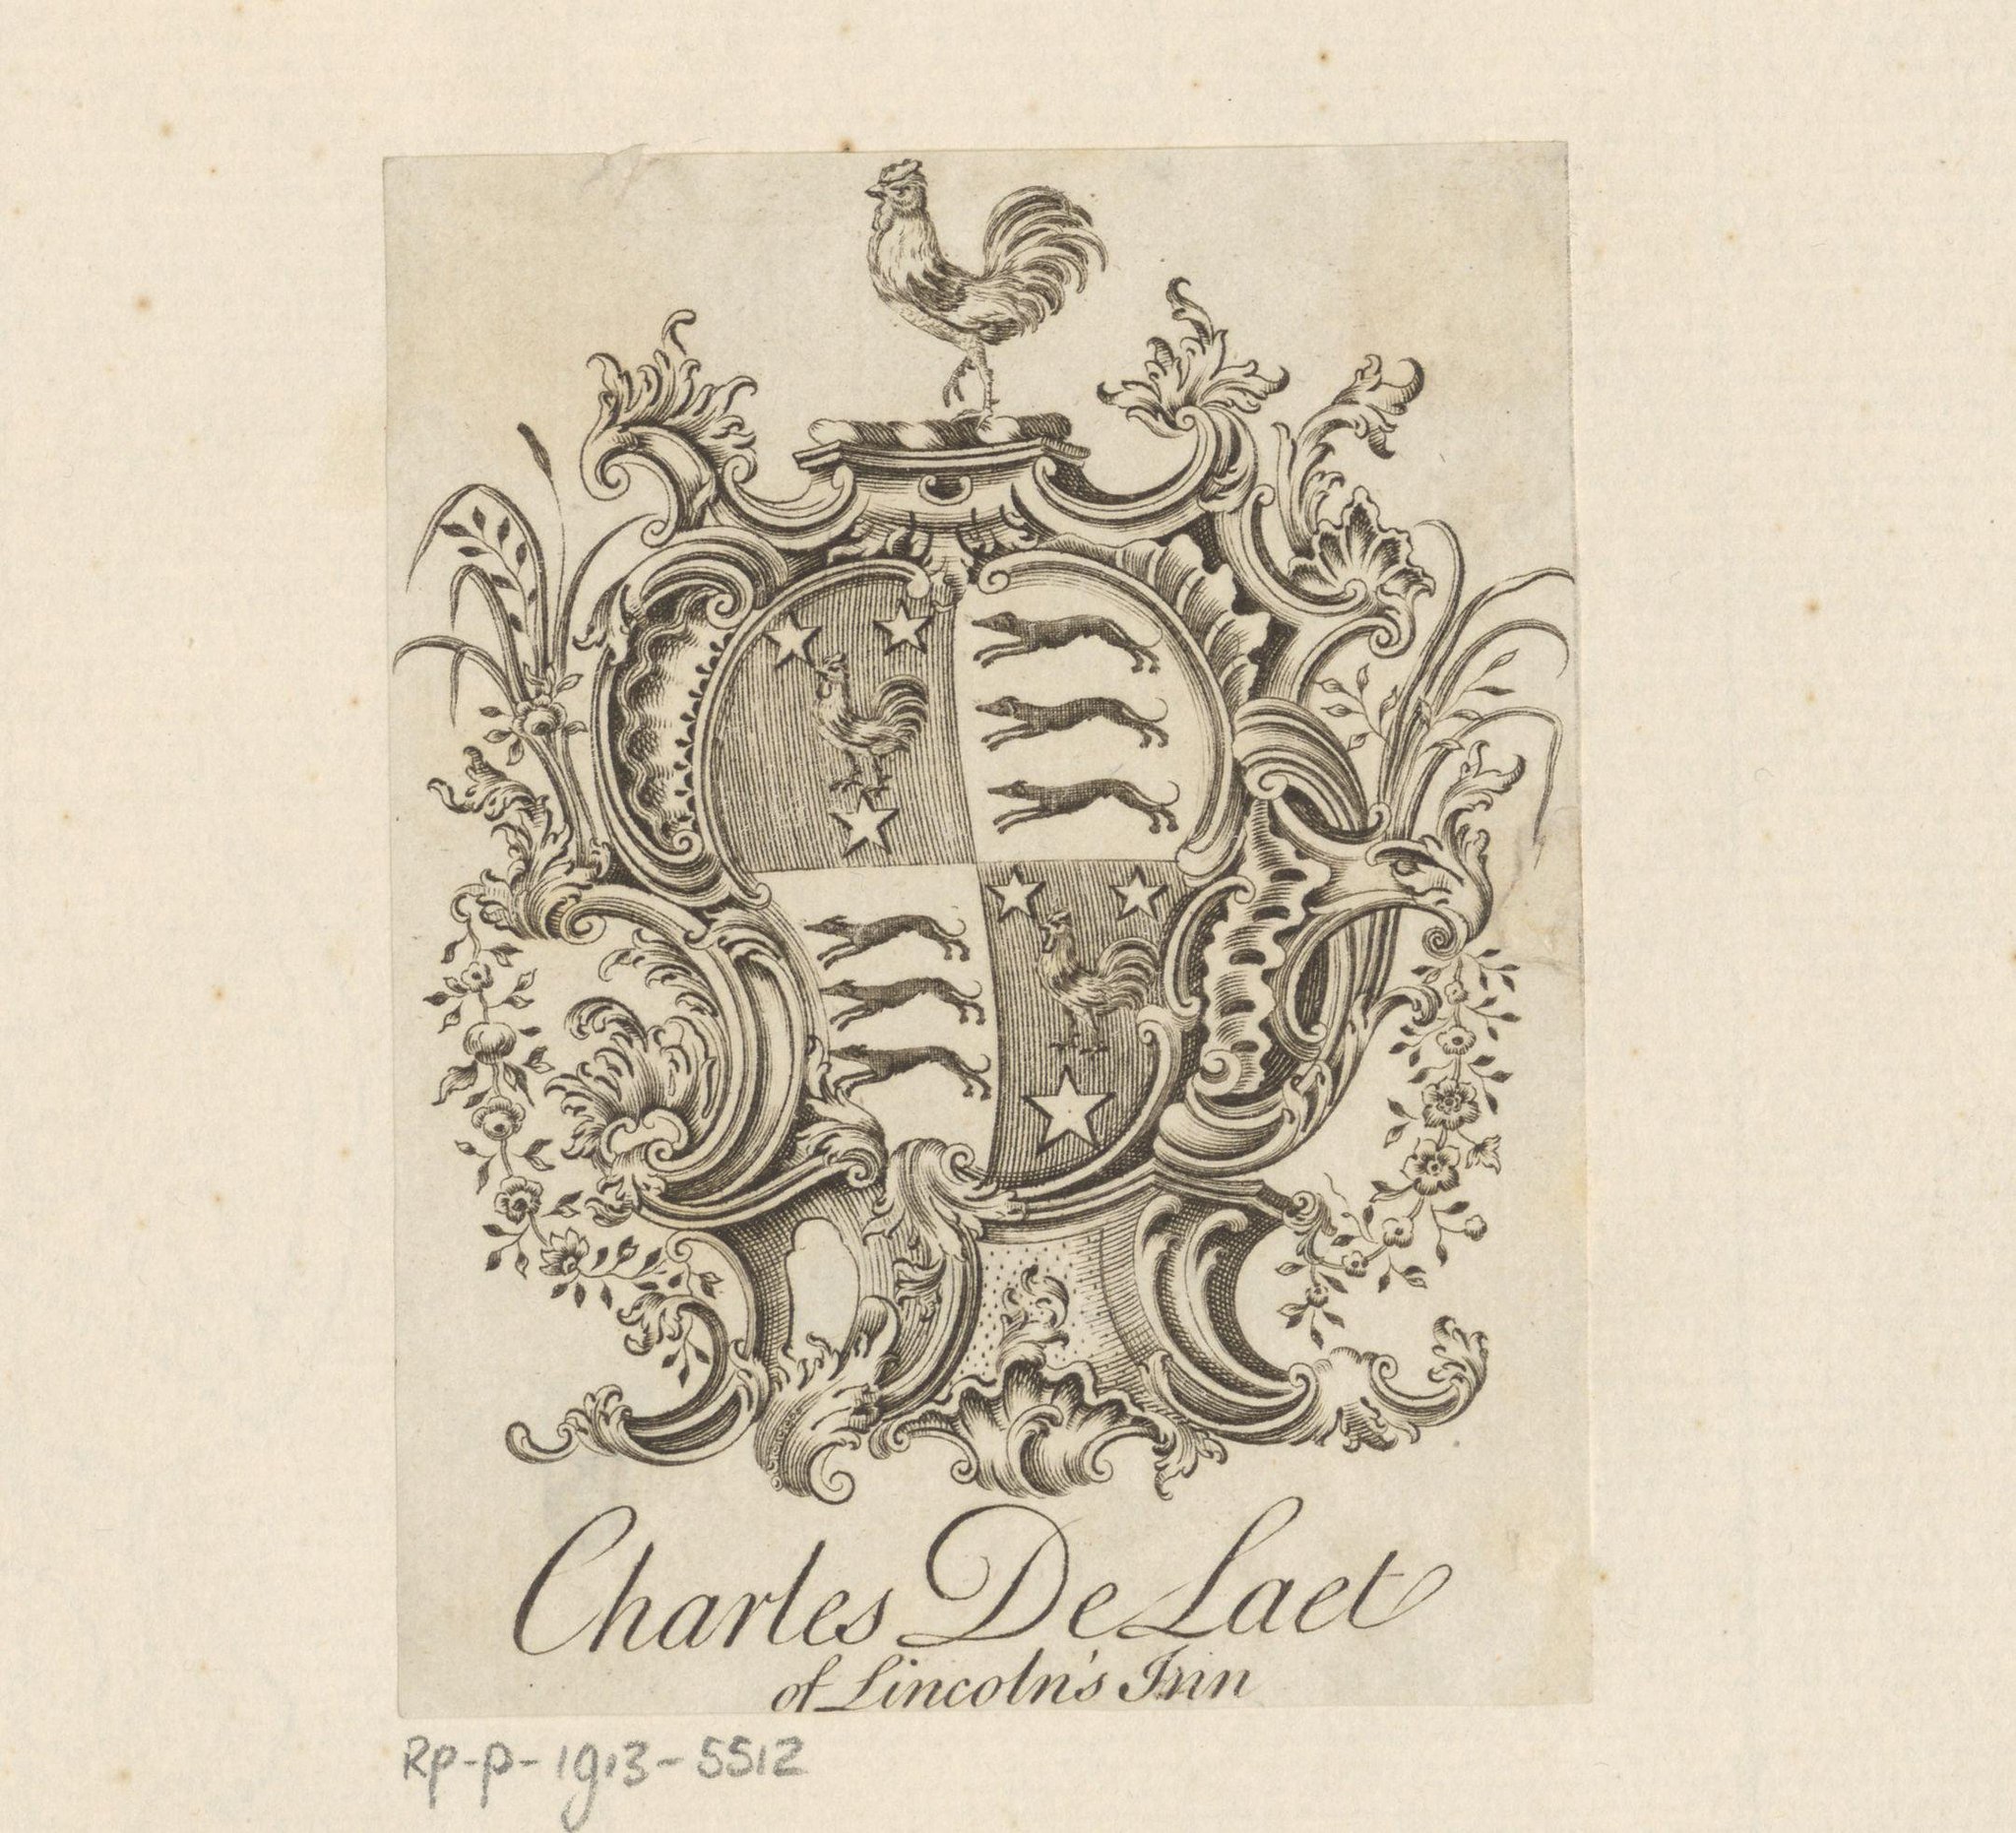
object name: bookplate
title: Ex libris van Charles De Laet of Lincoln's Inn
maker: Anonymous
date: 1700-1799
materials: paper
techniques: engraving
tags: armorial bearing, heraldry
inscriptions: collector's mark: Lugt 2233, collector's mark: Lugt 2760